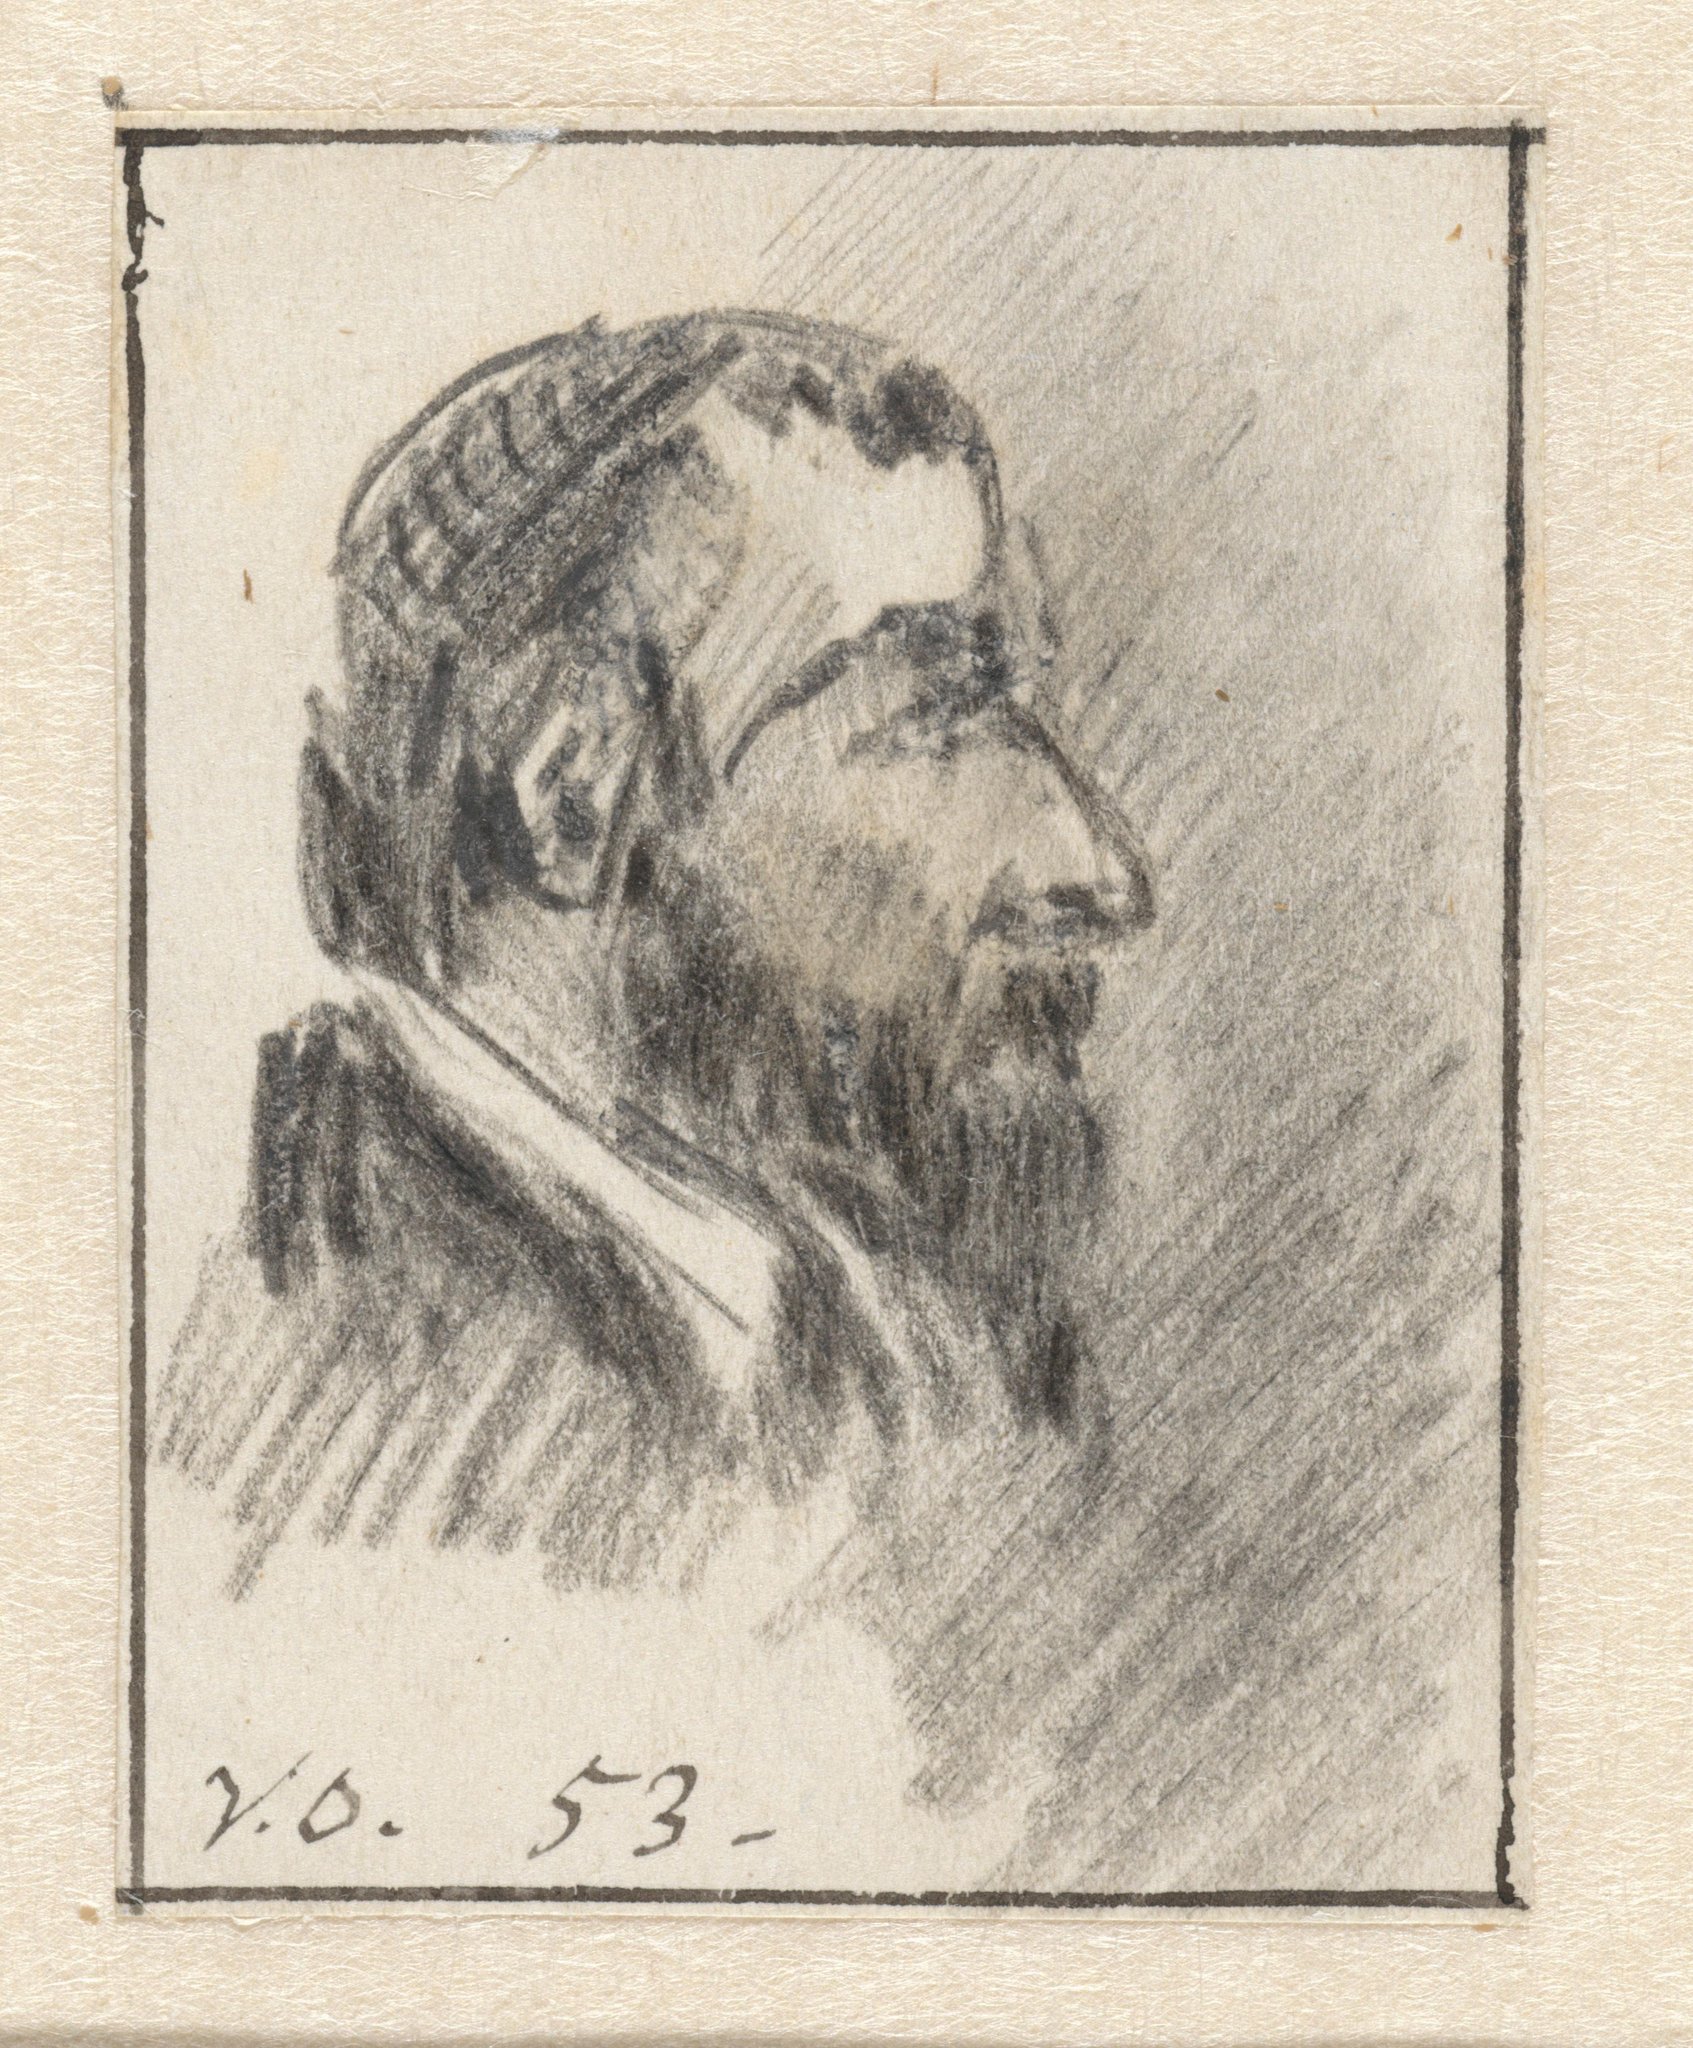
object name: drawing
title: Hoofd van man, in profiel naar rechts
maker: georgius jacobus johannes van os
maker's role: draughtsman, painter, print maker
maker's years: 1782-1861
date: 1853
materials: paper, pencil